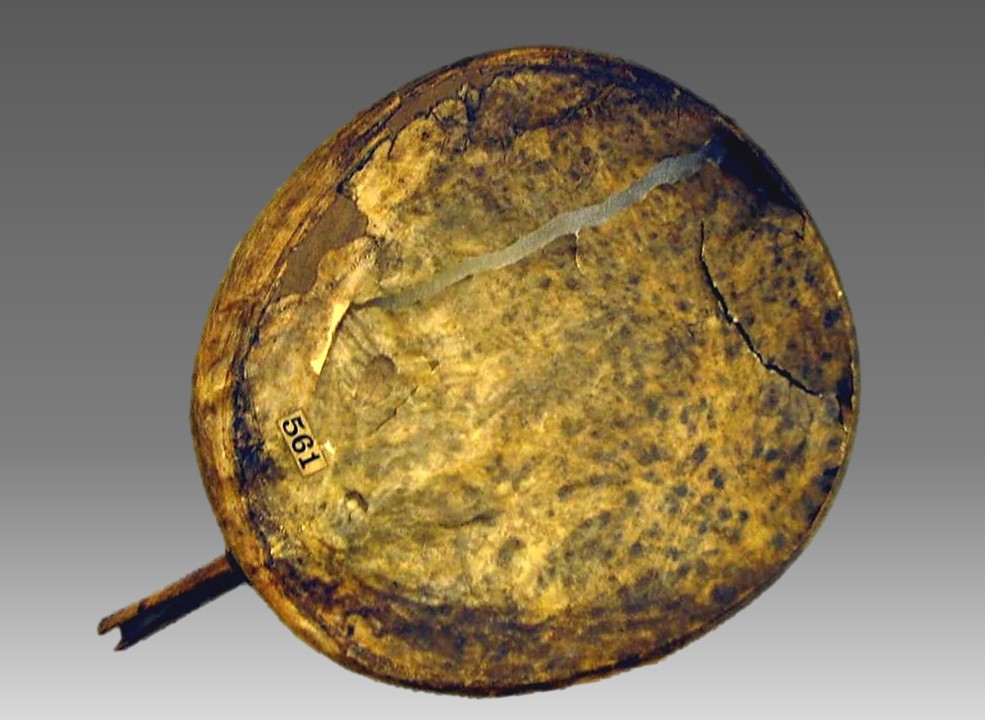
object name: kelyaut frame drum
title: Kelyaut (frame drum)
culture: native american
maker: northern alaskan eskimo; family: eskimavan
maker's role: maker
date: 1801-1900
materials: wood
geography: united states